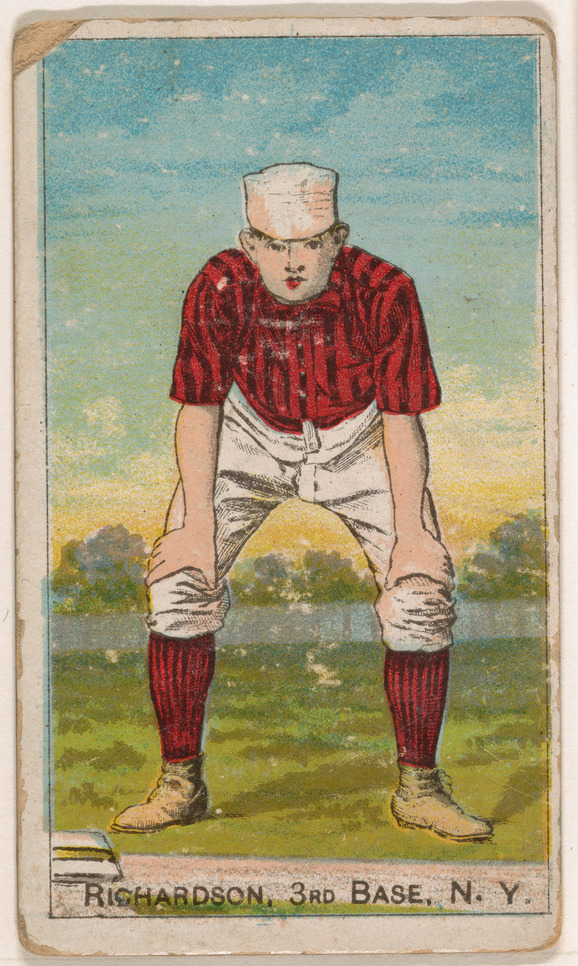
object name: baseball card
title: Richardson (Hands At Knees), 3rd Base, New York, from the Gold Coin series (N284) for Gold Coin Chewing Tobacco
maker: d. buchner & co., new york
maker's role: publisher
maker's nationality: american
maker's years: 1850-1900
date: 1887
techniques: color lithograph, drawing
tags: men,baseball,athletes